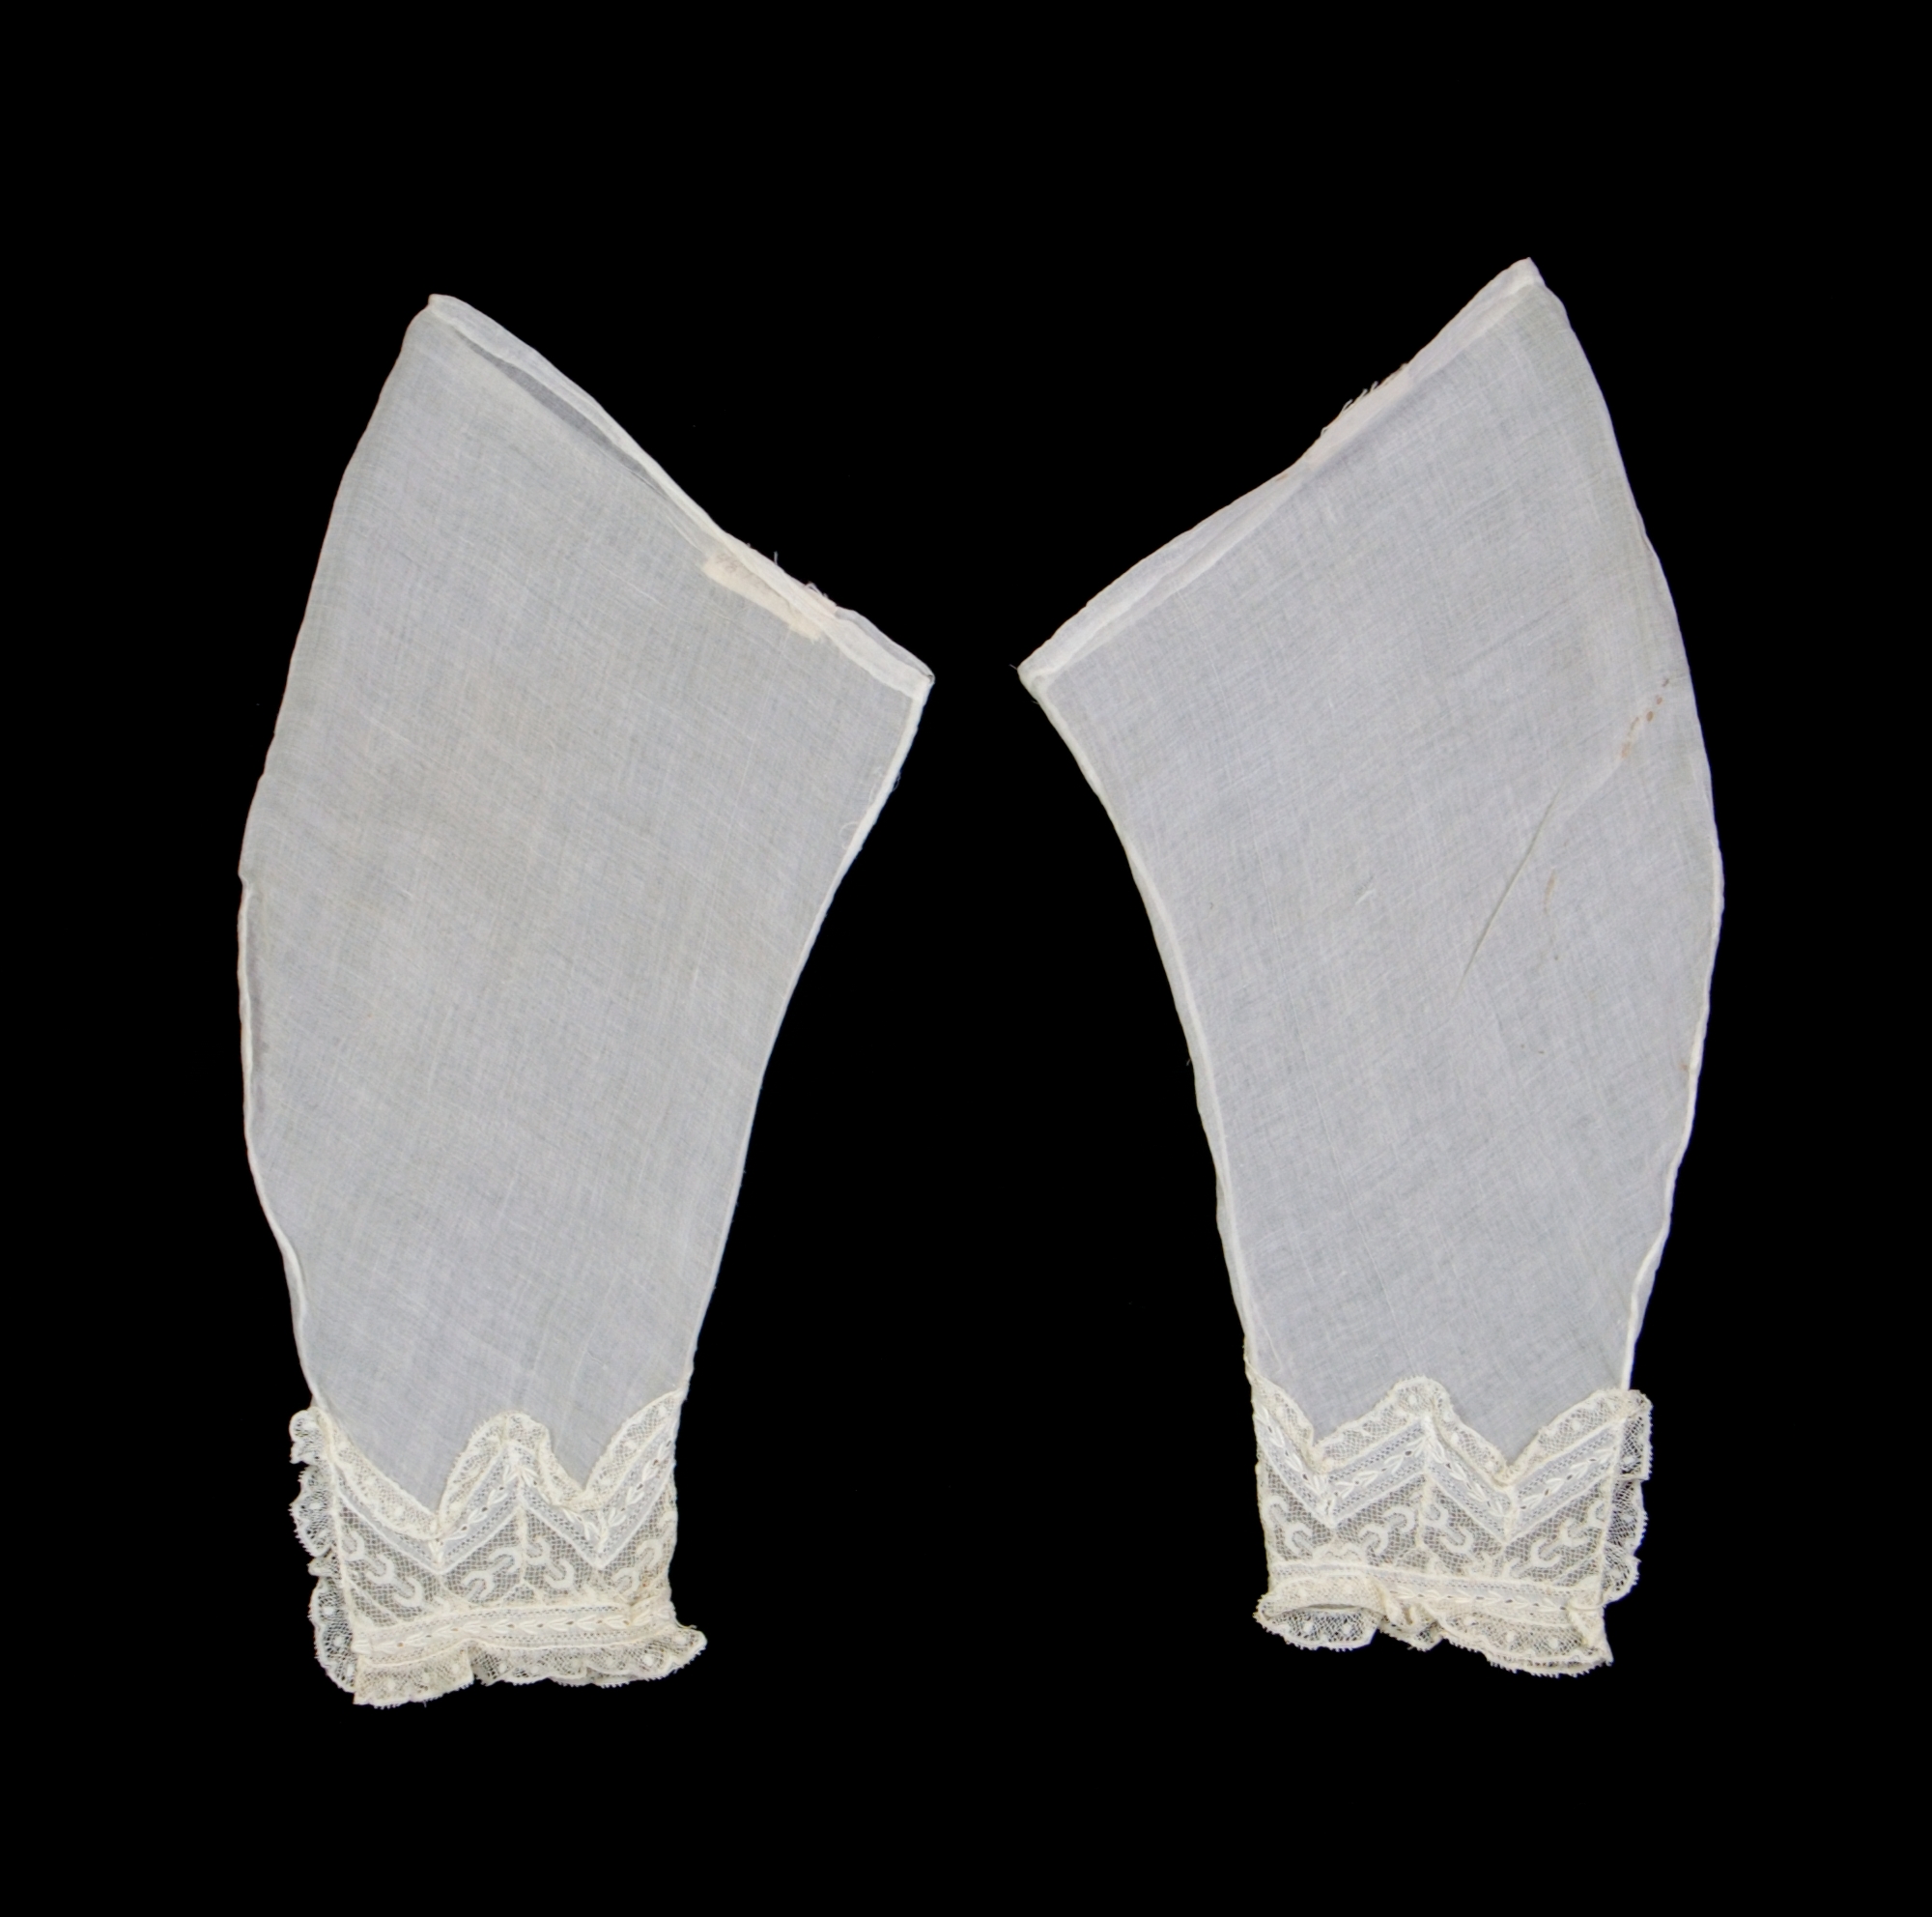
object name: undersleeves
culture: american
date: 1870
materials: linen